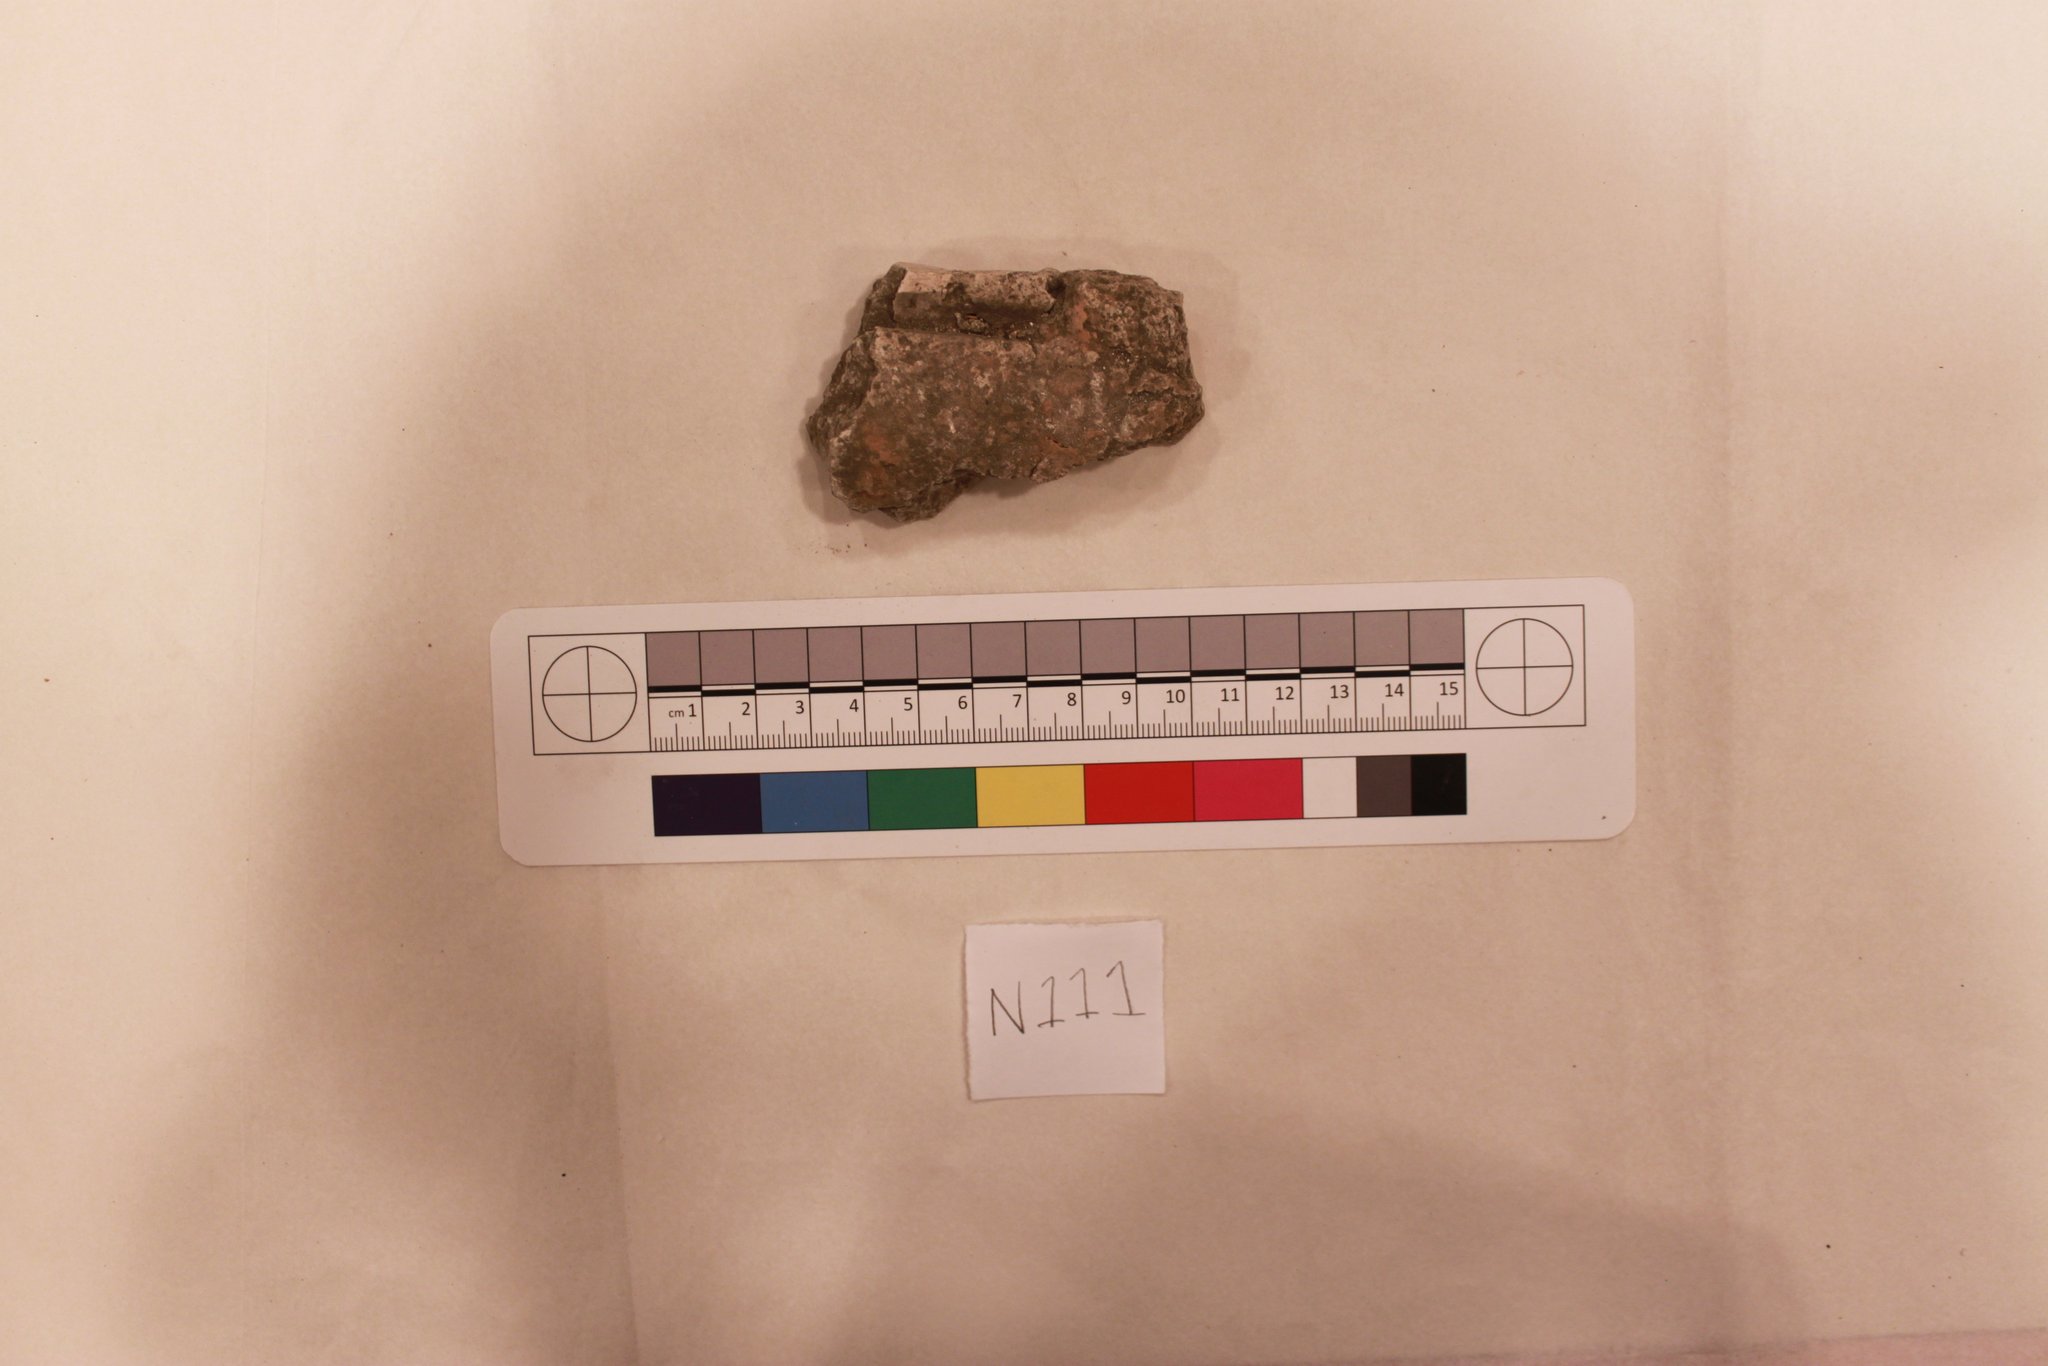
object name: fragment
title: Stucco Fragment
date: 701-1200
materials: plaster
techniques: carving, painting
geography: iran